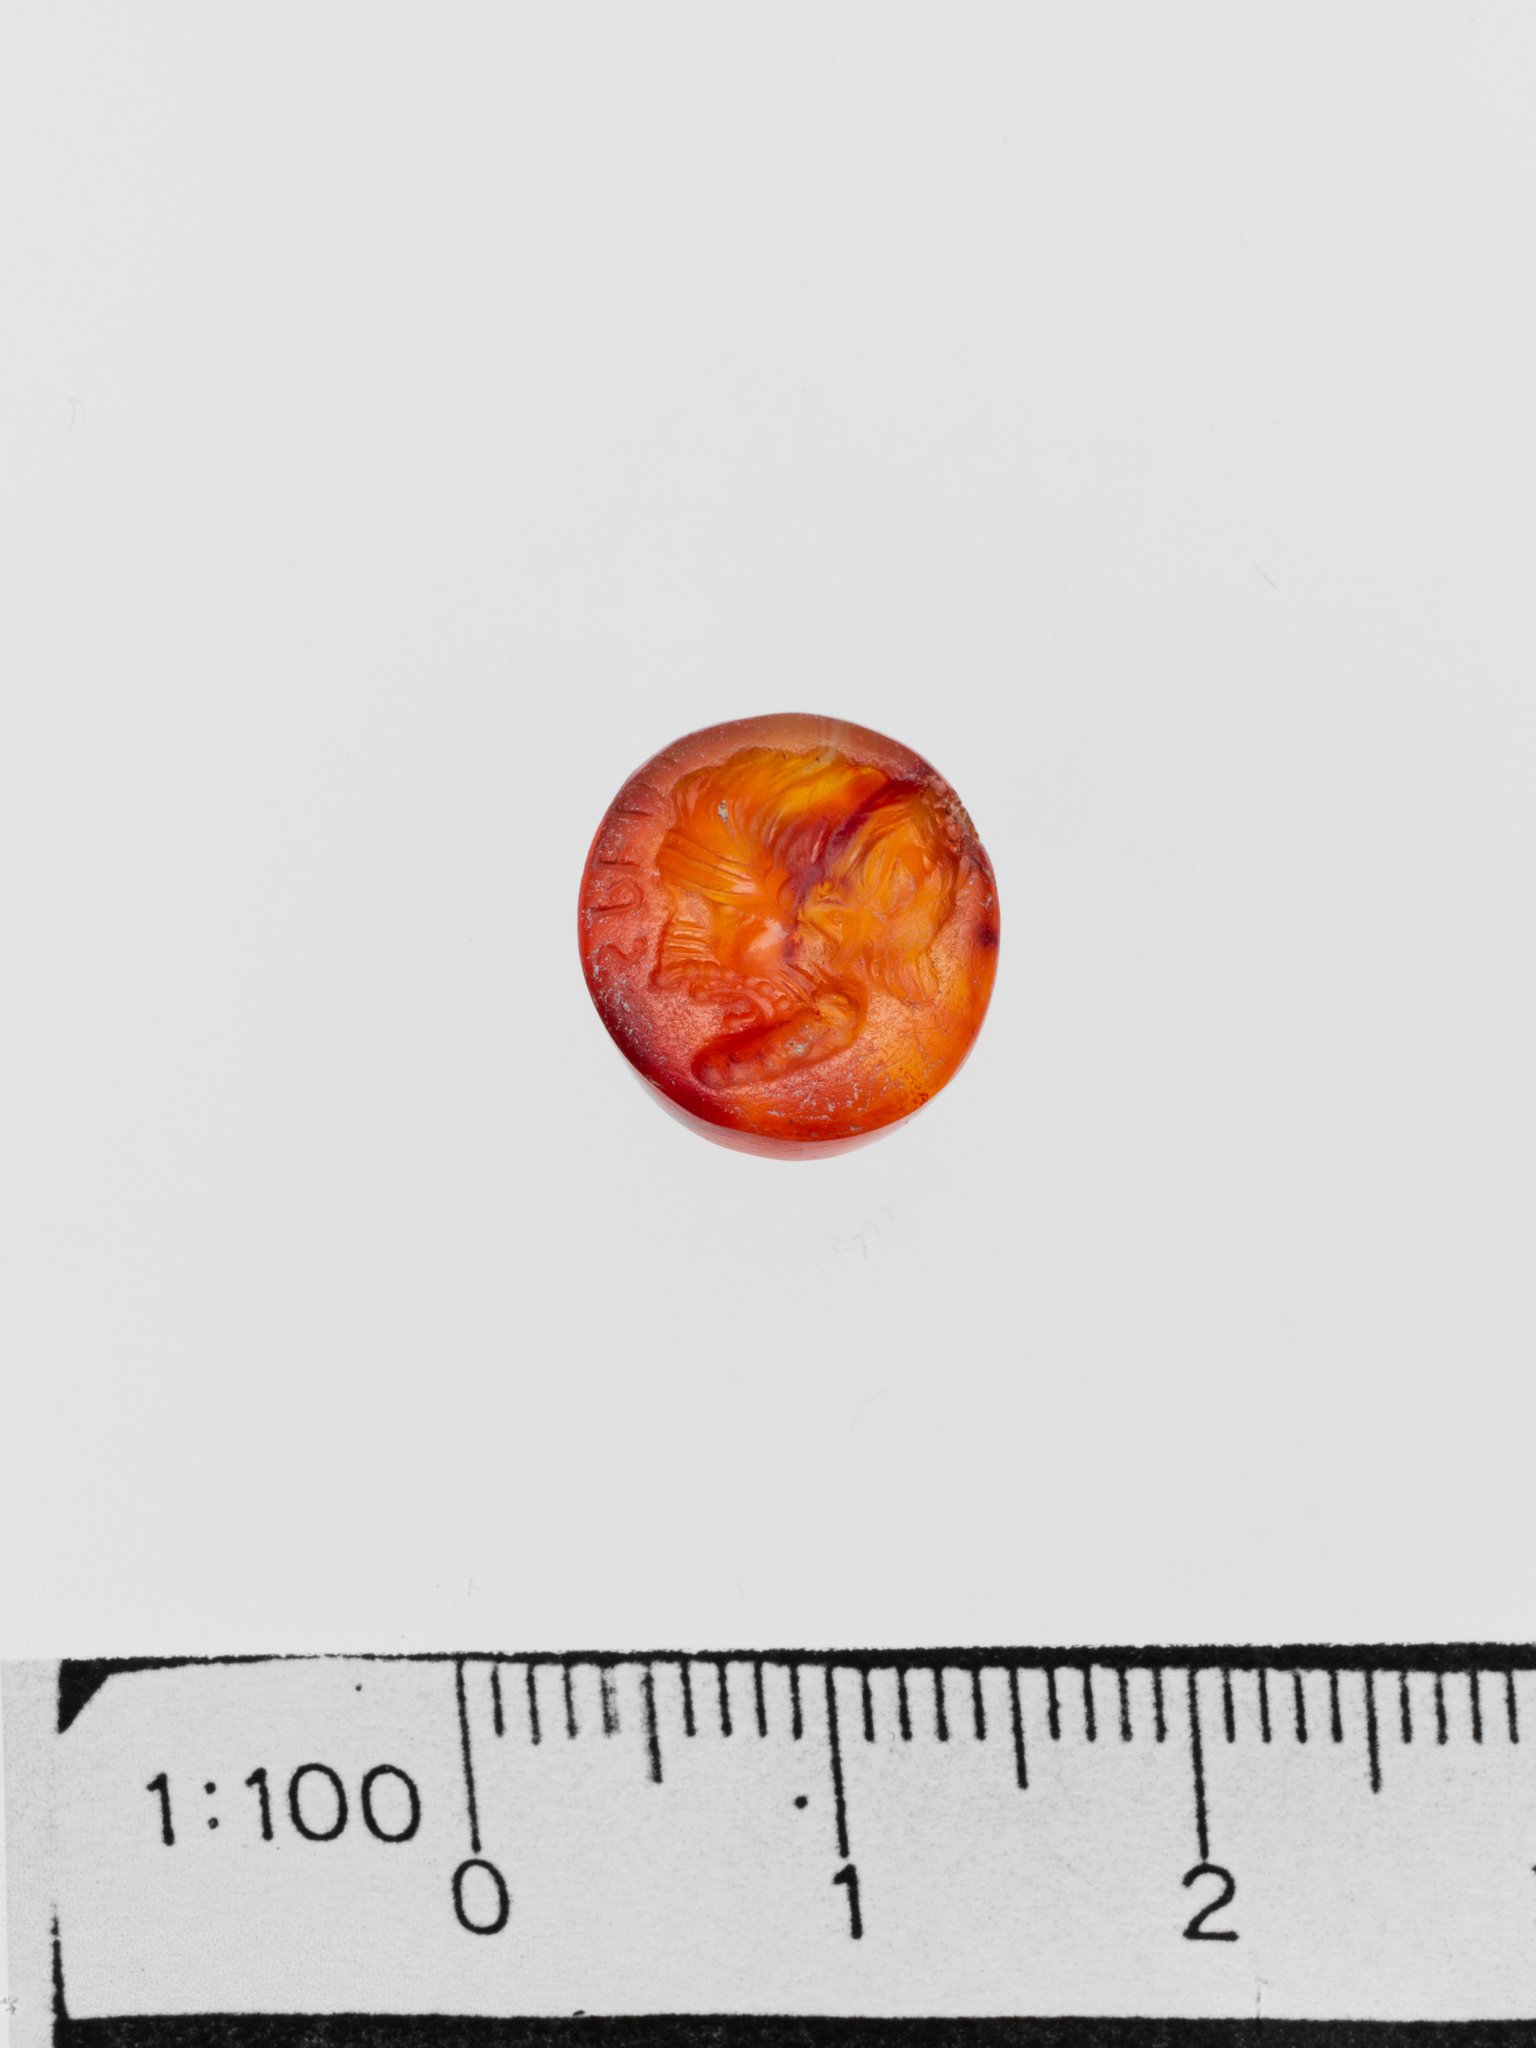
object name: intaglio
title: Carnelian ring stone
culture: italic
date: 300-101 BCE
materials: gemstone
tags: men,profiles